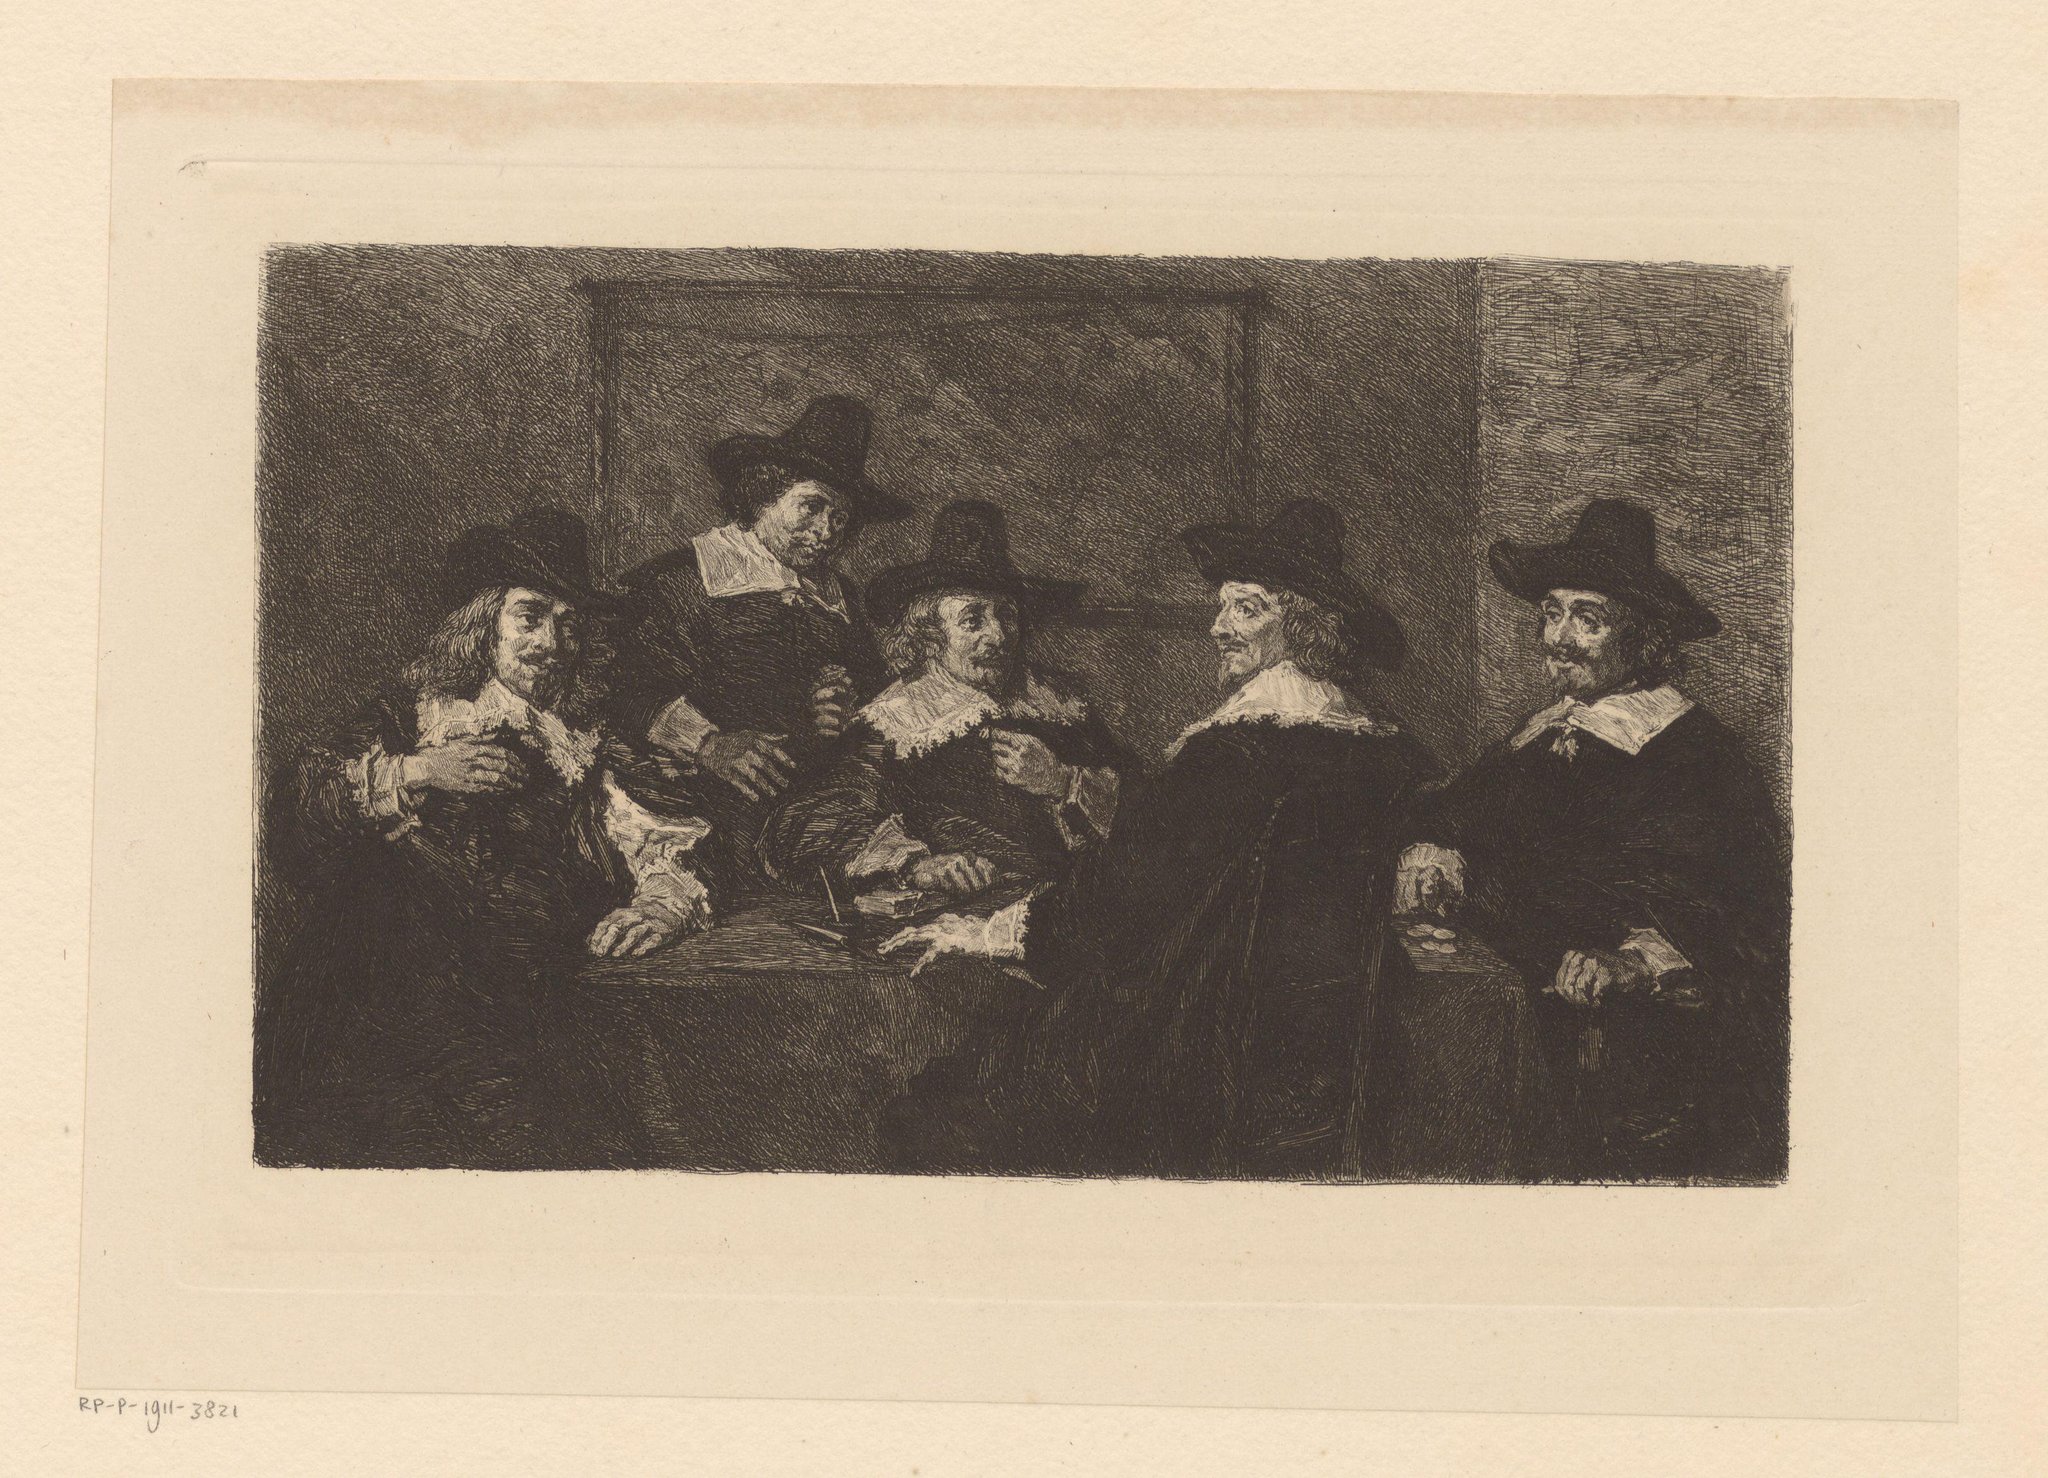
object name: print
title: Regenten van het Haarlemse Sint Elisabeths Gasthuis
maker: william unger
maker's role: draughtsman, painter, print maker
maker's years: 1837-1932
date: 1847-1889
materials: paper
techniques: etching, intaglio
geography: haarlem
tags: haarlem, maps, atlases, historical persons, board, esp. governors, trustees, etc. (dutch: 'regenten') - aa - women (dutch: 'regentessen')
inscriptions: collector's mark: Lugt 2228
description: Prent naar het schilderij door Frans Hals in het Frans Halsmuseum te Haarlem (inv.nr. os I-114).